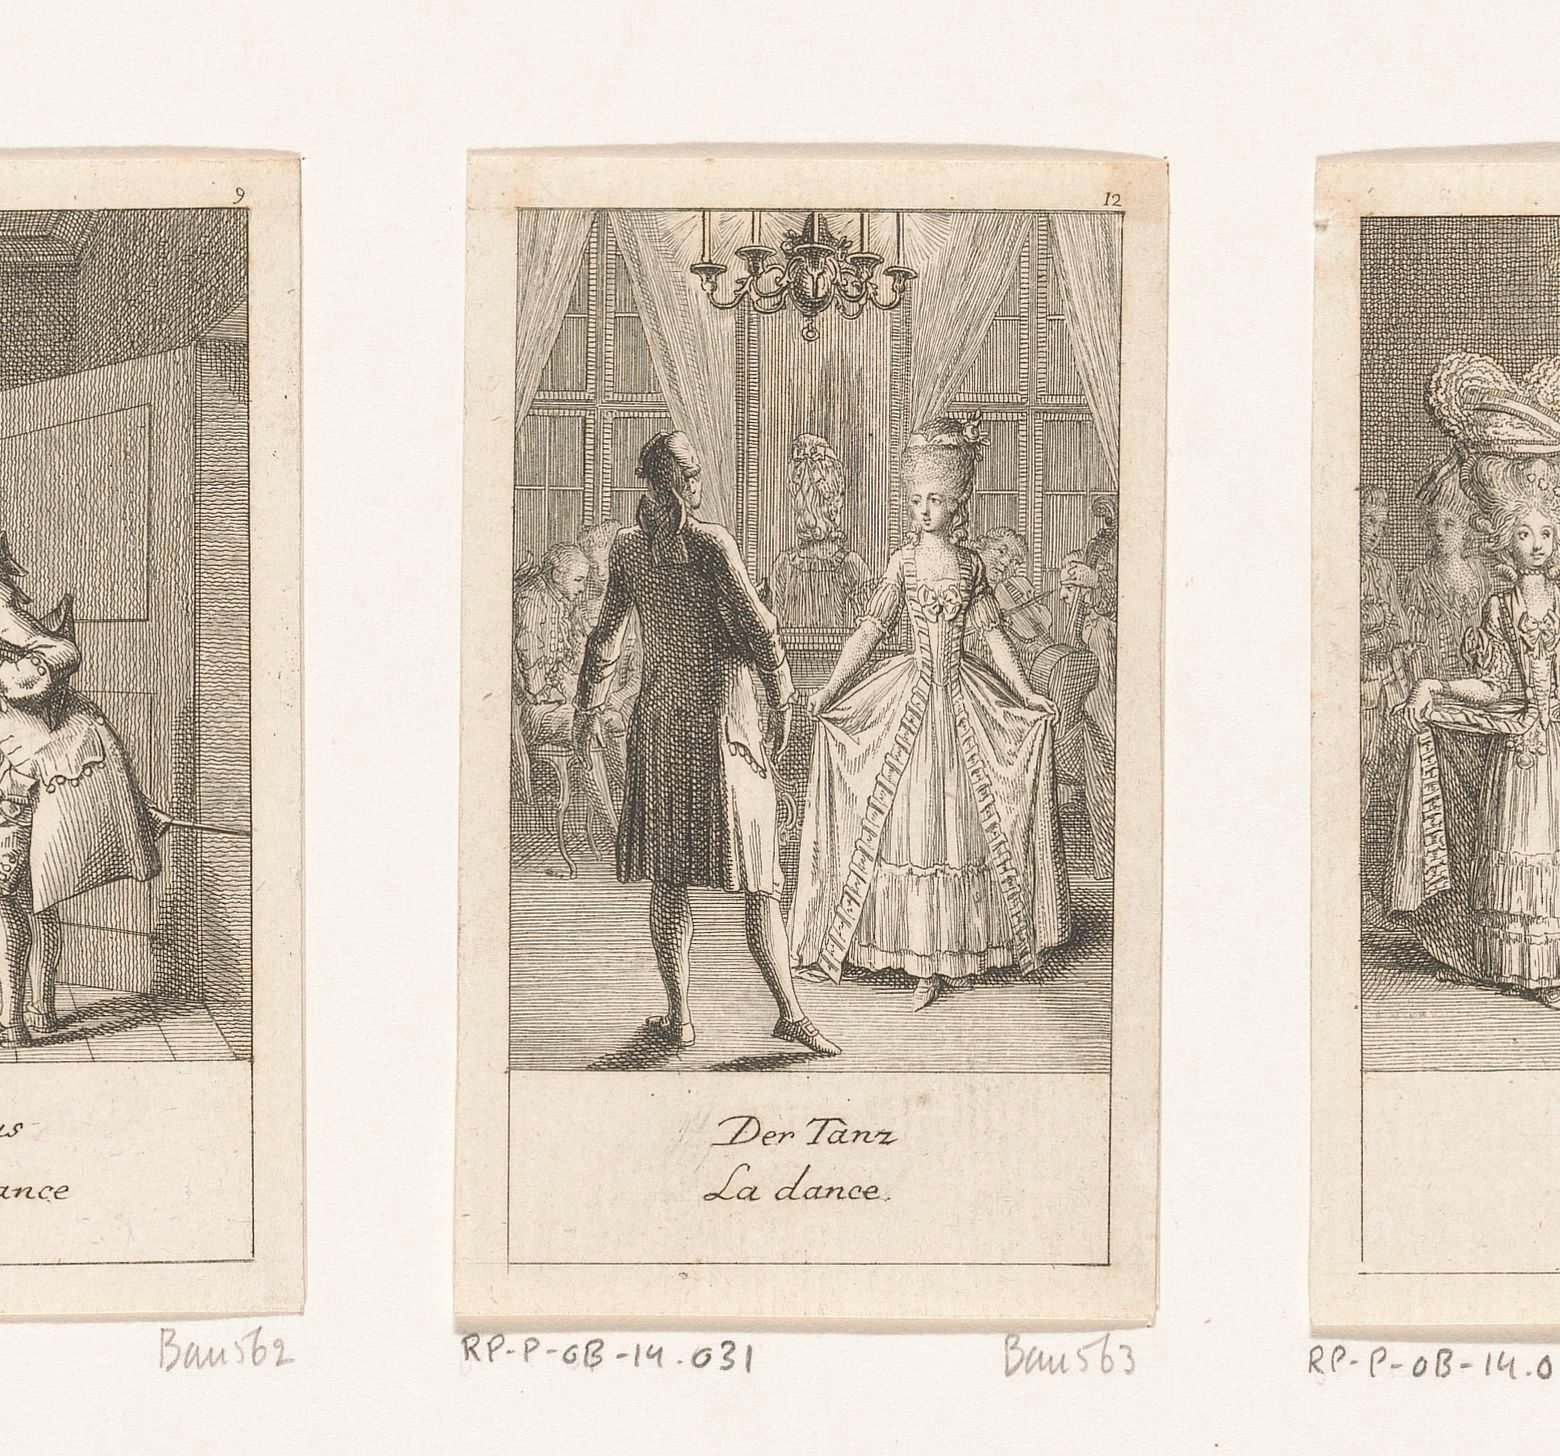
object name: print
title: Der Tanz / La dance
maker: daniel nikolaus chodowiecki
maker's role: draughtsman, print maker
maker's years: 1726-1801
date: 1778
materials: paper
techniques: etching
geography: berlin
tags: physicist, making music; musician with instrument, ball, formal dance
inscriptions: collector's mark: Lugt 2228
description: Twaalfde prent uit een serie van twaalf taferelen die 'Natürliche und affectirte Handlungen des Lebens' (eerste serie) illustreren waarin 'natuurlijk' en 'geaffecteerd' gedrag op karikaturale wijze tegenover elkaar worden gezet. Deze taferelen zijn op een plaat geëtst. Deze serie, voorzien van toelichtingen door Georg Christoph Lichtenberg, is ook gebruikt in: Goettinger Taschen Calender vom Jahre 1779. Göttingen: Johann Christian Dieterich.